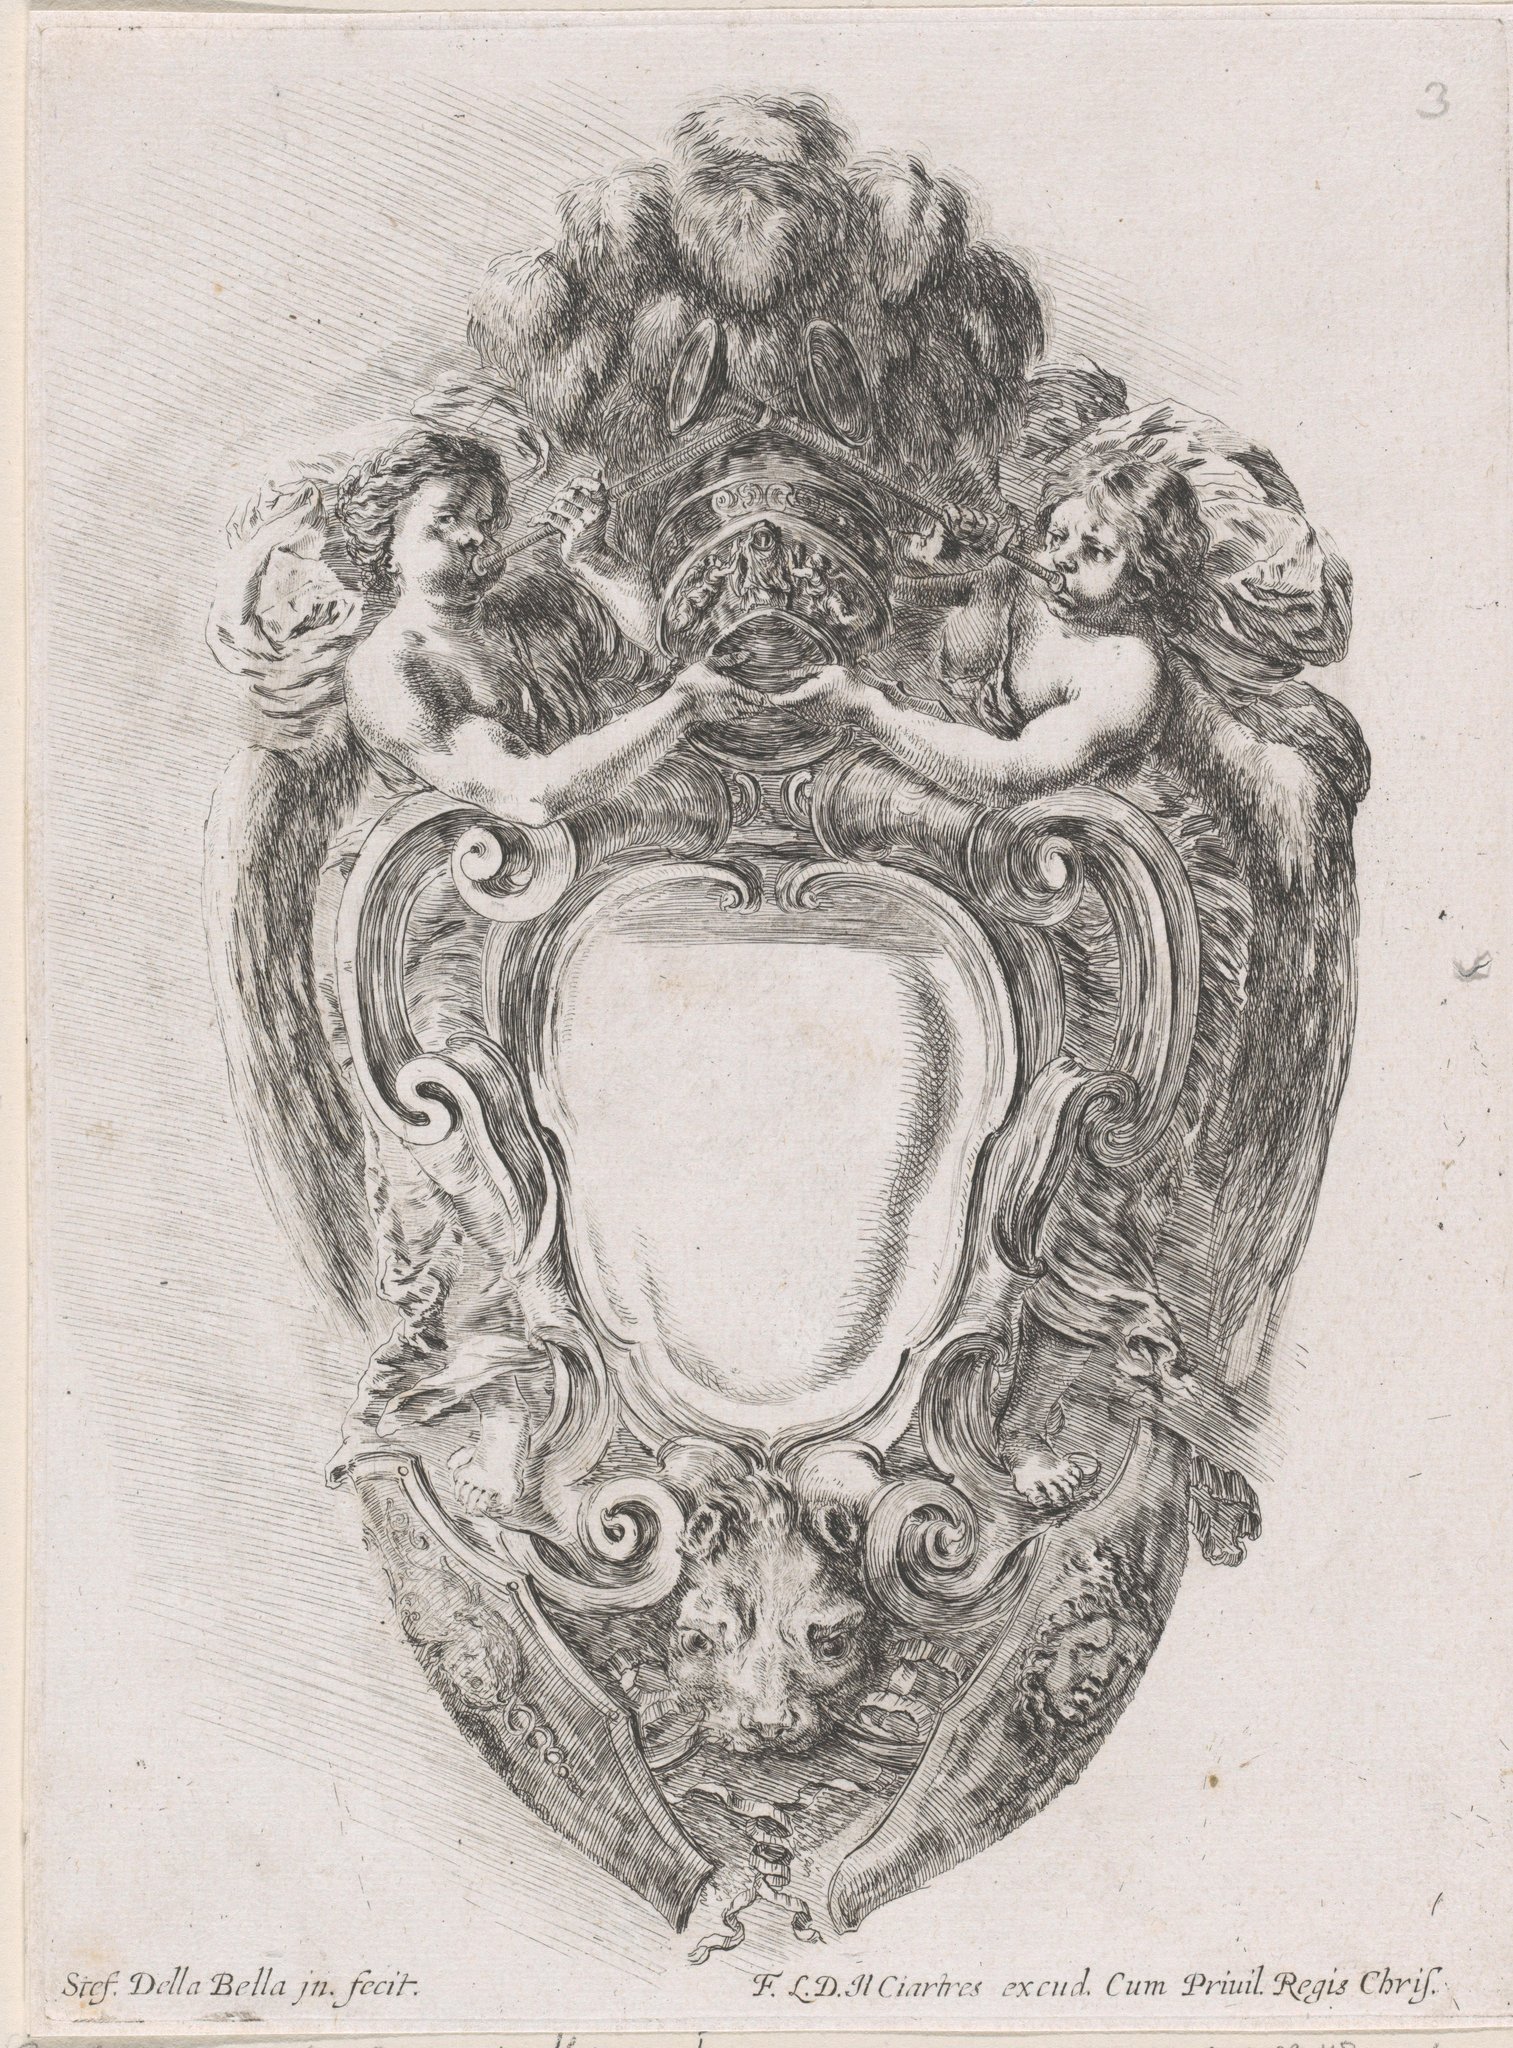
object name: print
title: Raccolta di varii cappricii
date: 1646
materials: paper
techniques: etching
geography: france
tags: helmet, lion's head ~ ornament, ornament ~ cartouche, angels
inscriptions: collector's mark: Lugt 240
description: Prent uit een reeks van achttien prenten.